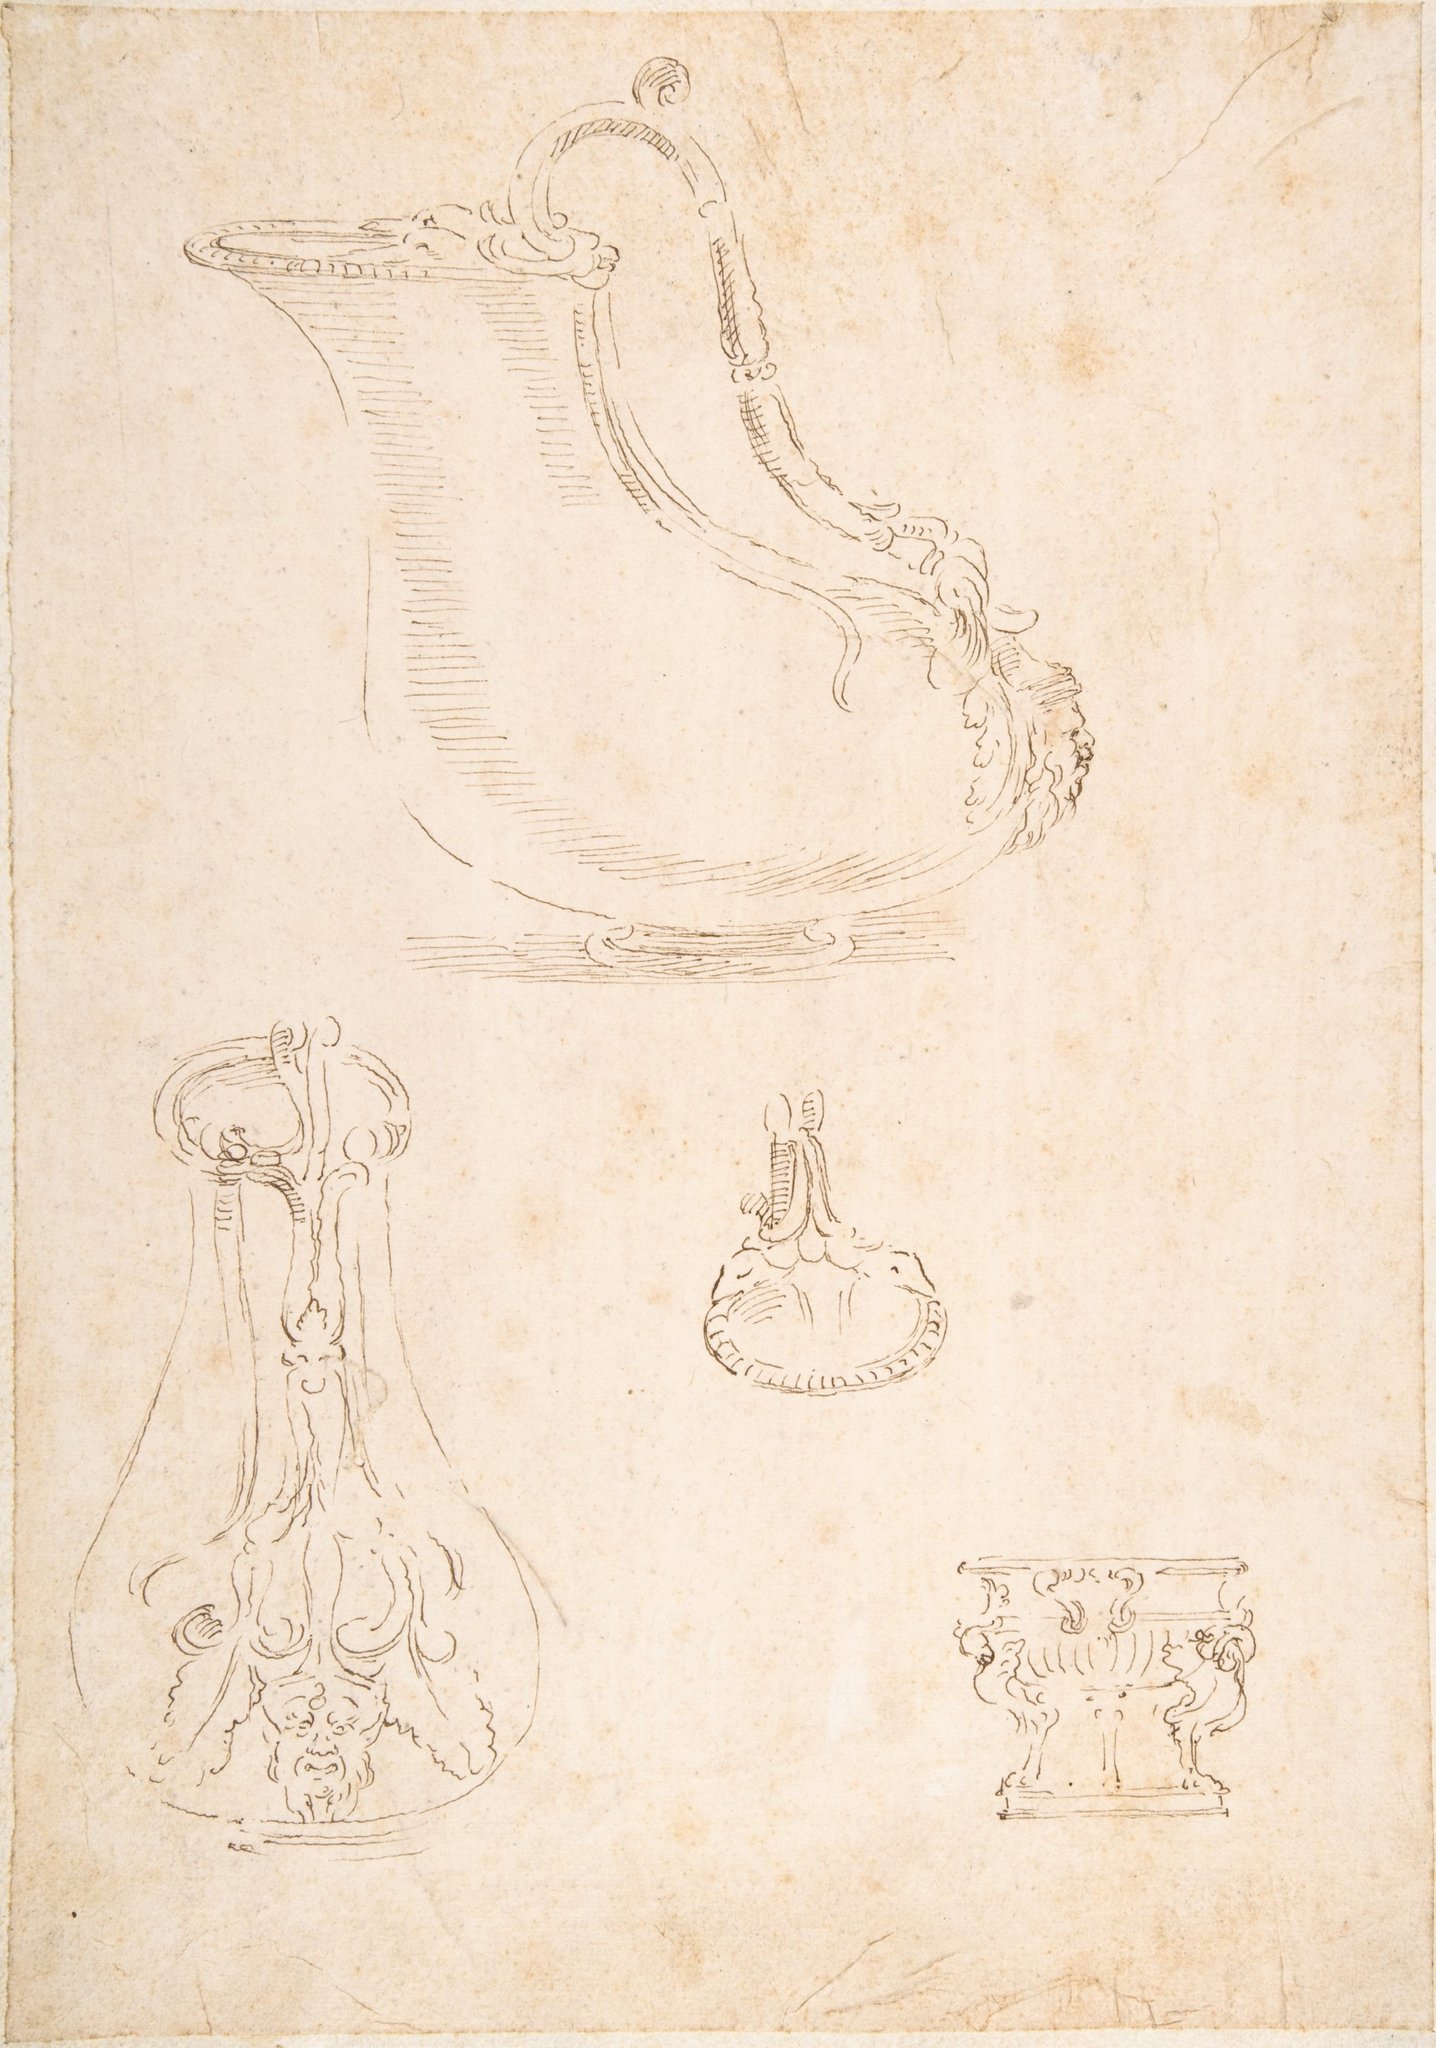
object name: drawing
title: Design for Vessels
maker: anonymous, italian, 16th century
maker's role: artist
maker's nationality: italian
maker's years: 1550-1600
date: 1501-1533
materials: ink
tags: vessels